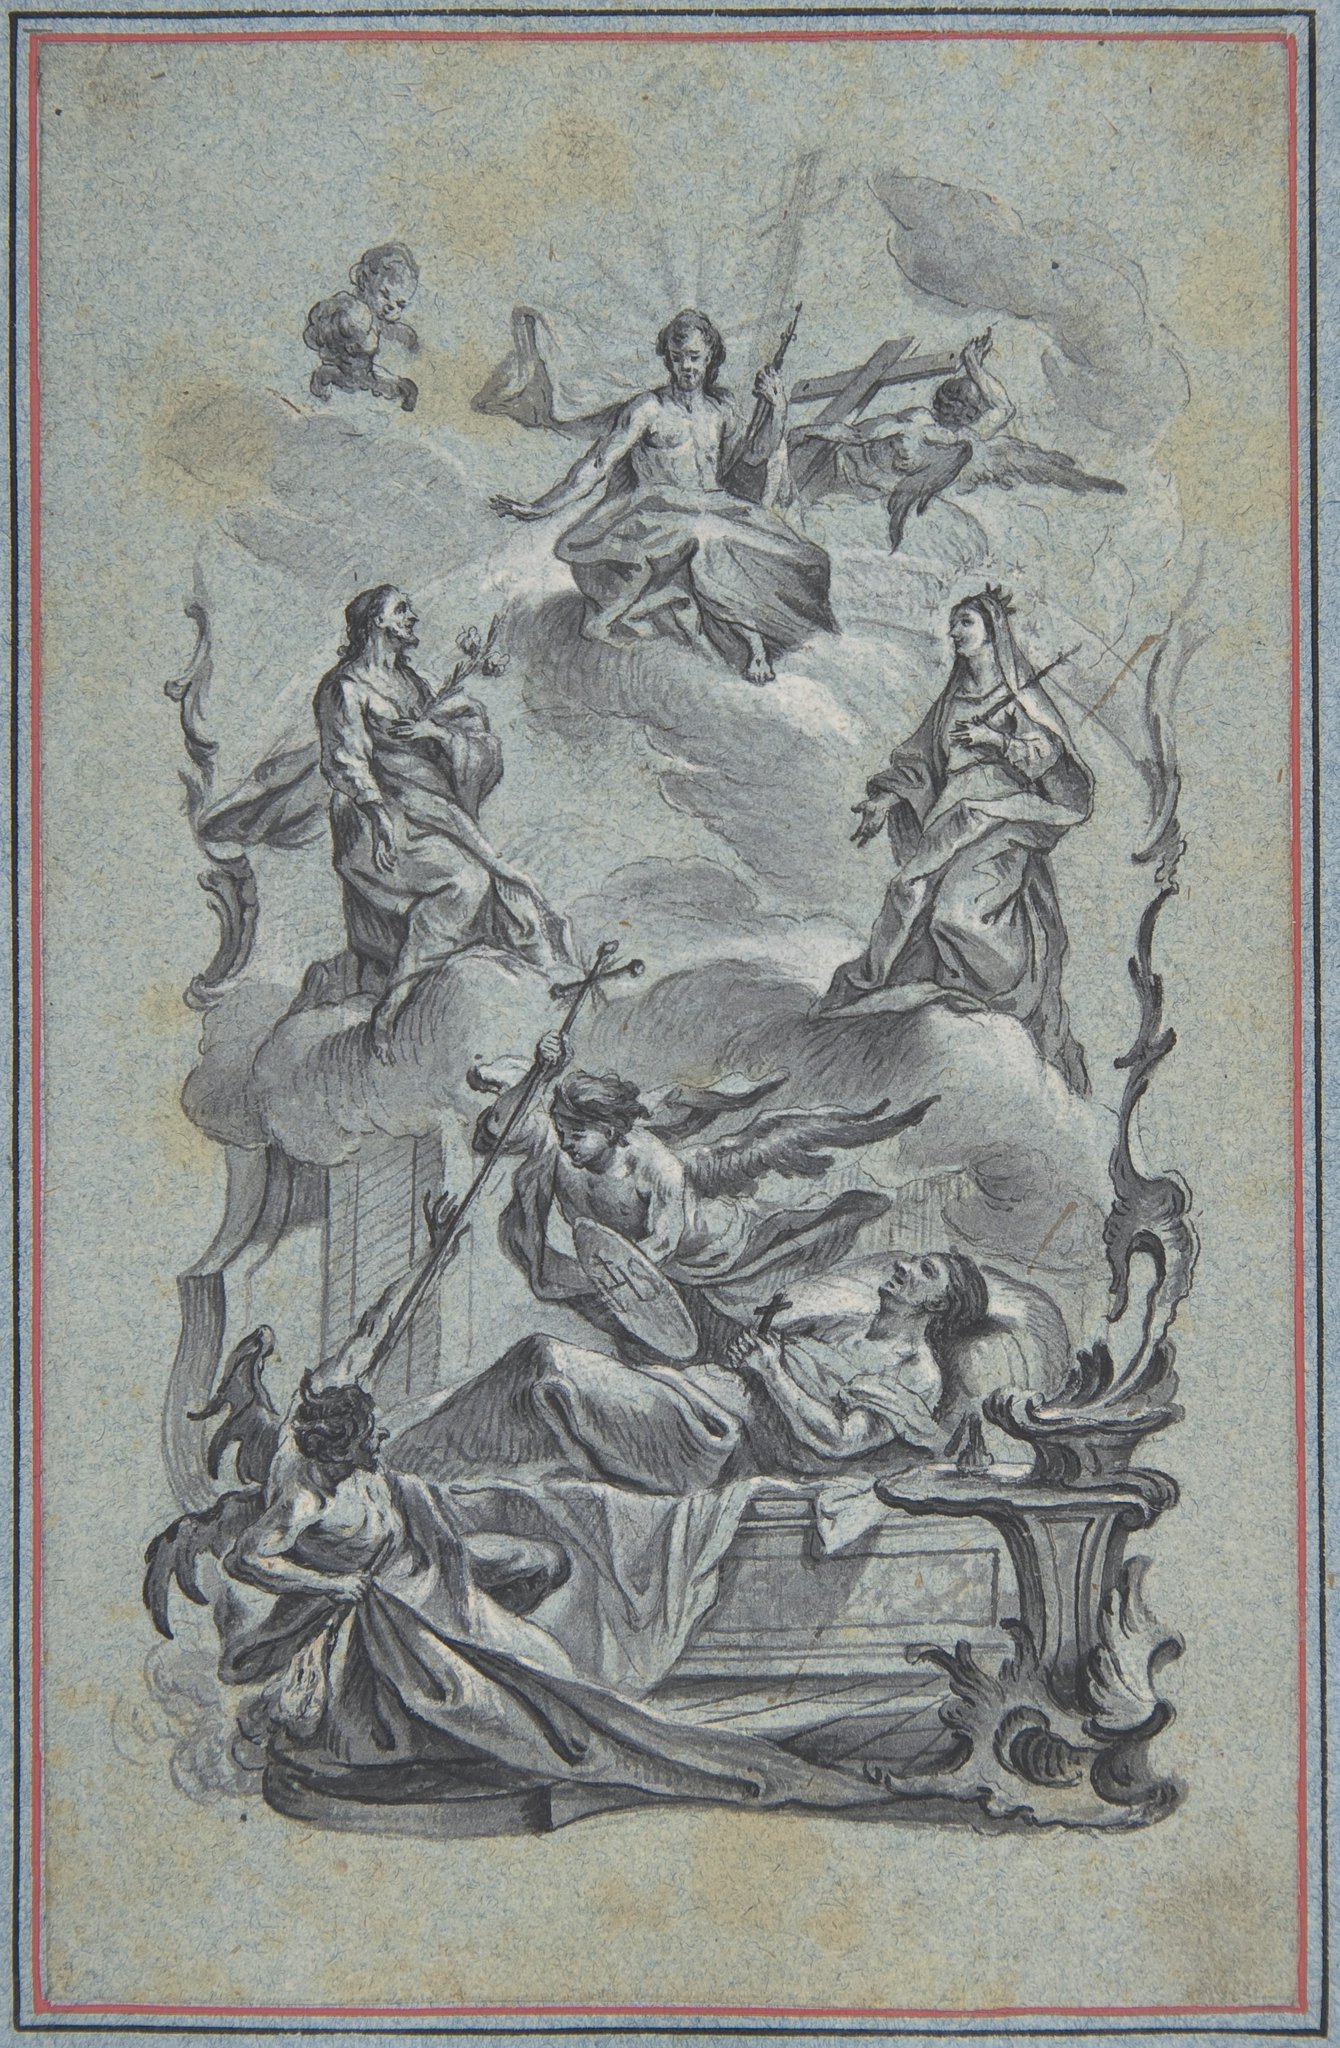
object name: drawing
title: Saint Michael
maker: josef christ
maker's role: artist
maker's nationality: german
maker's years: 1732-1788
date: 1732-1788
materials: ink, paper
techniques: heightening, pen, wash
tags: angels,saint michael